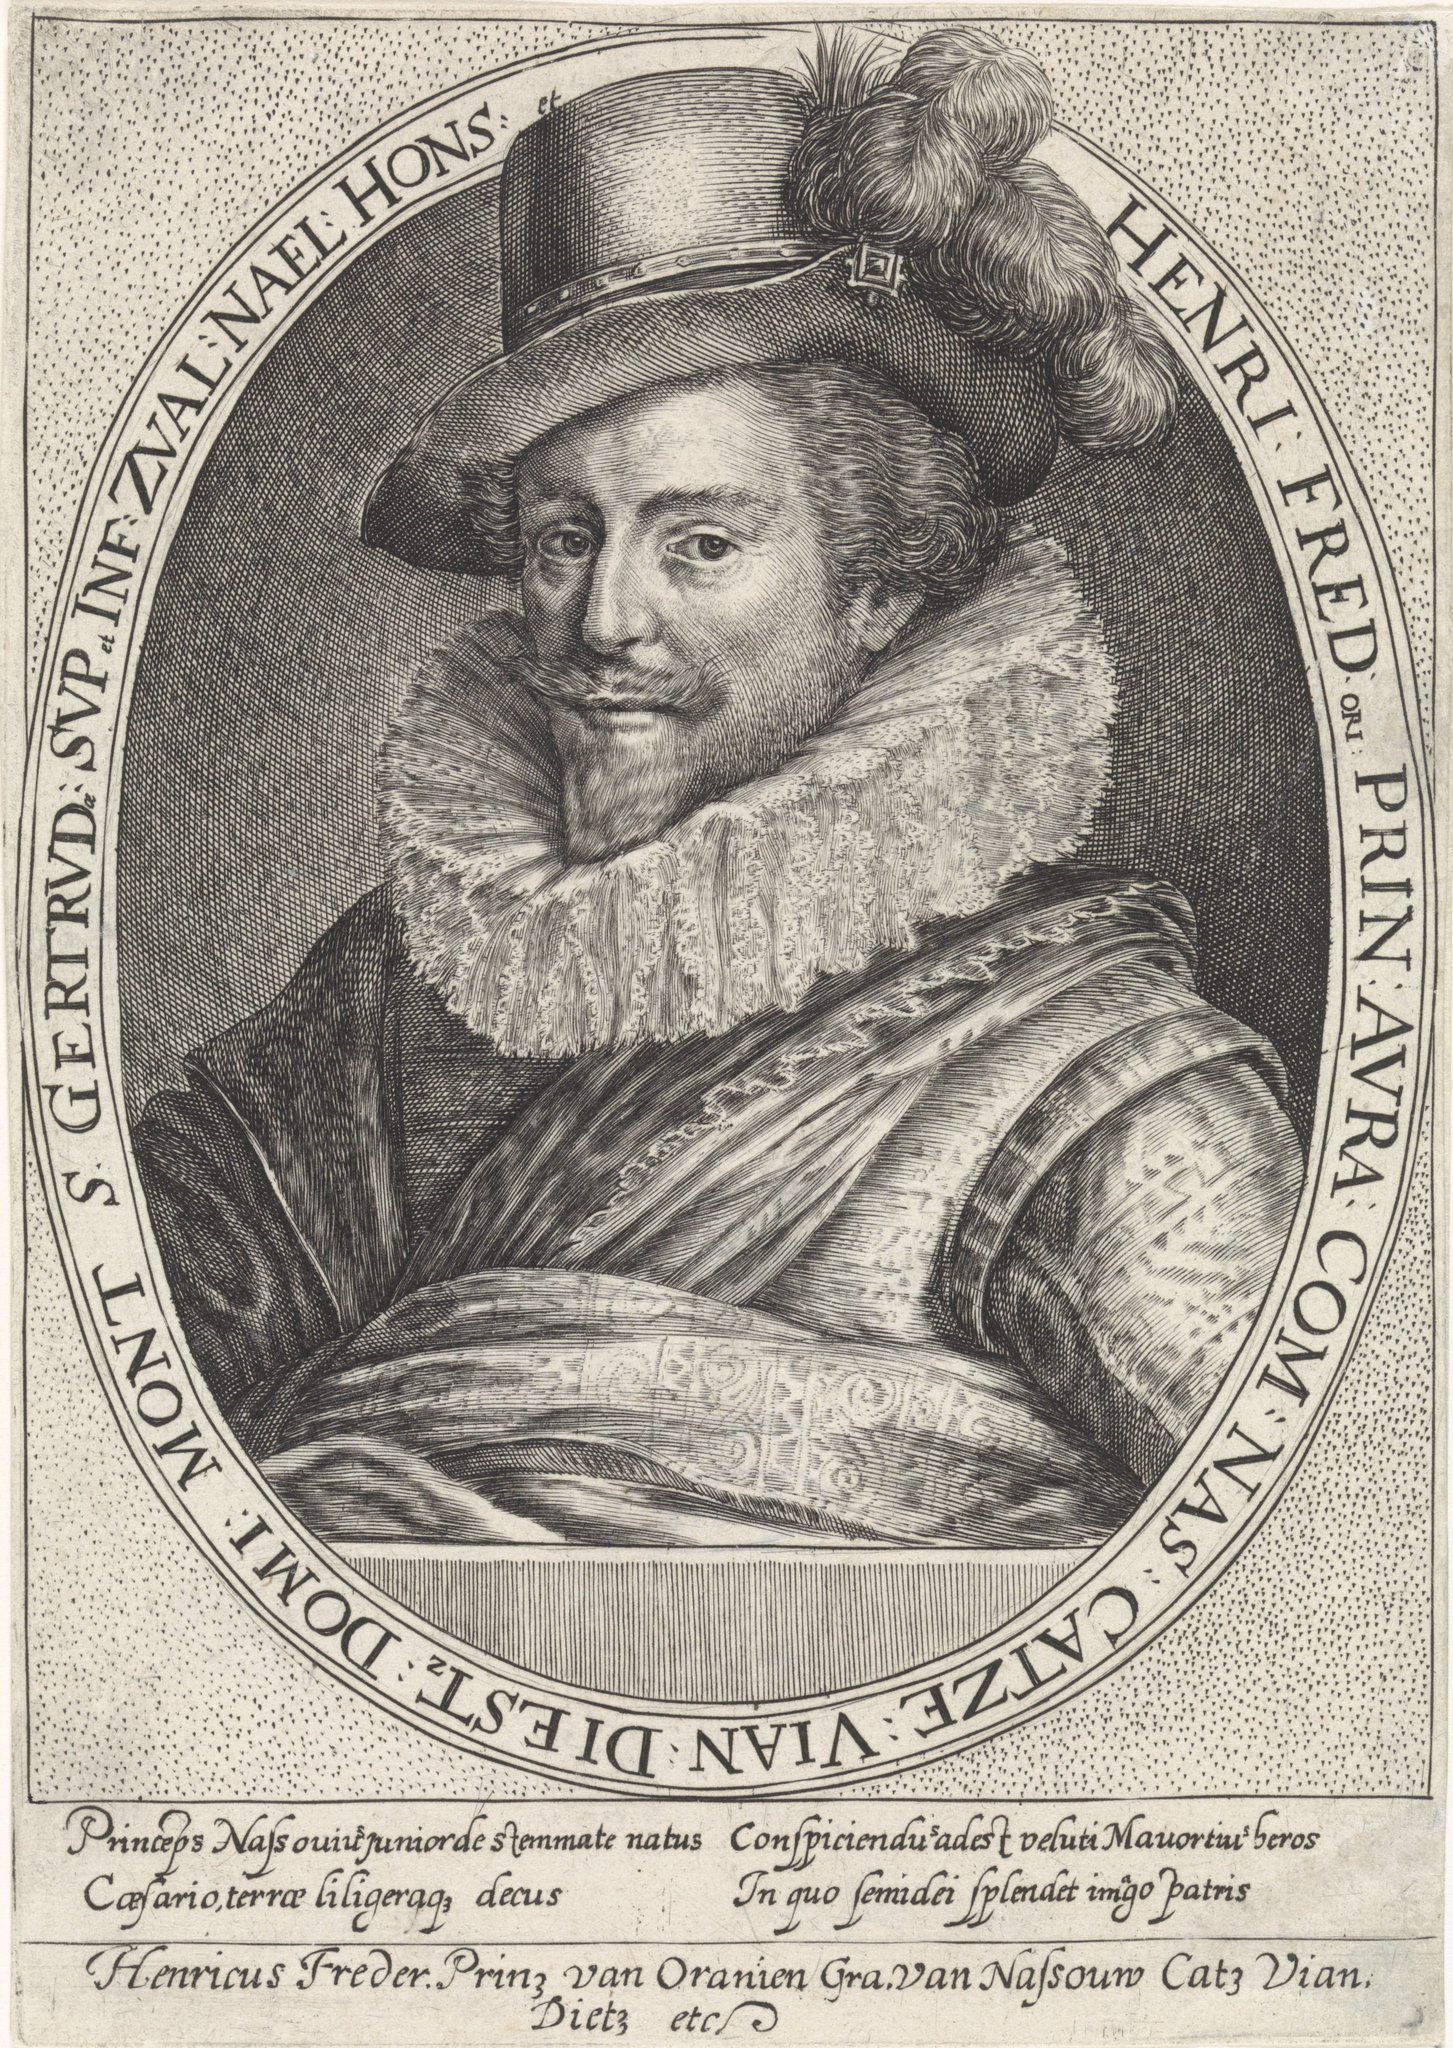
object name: print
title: Portret van Frederik Hendrik van Oranje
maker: crispijn van de passe (i)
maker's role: draughtsman, print maker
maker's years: 1564-1637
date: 1574-1637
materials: paper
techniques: engraving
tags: delft, frederick henry (prince of orange)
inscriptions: collector's mark: Lugt 2228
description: Portret van Frederik Hendrik, prins van Oranje-Nassau. In de marge een vierregelig lofdicht, in twee kolommen, in het Latijn.